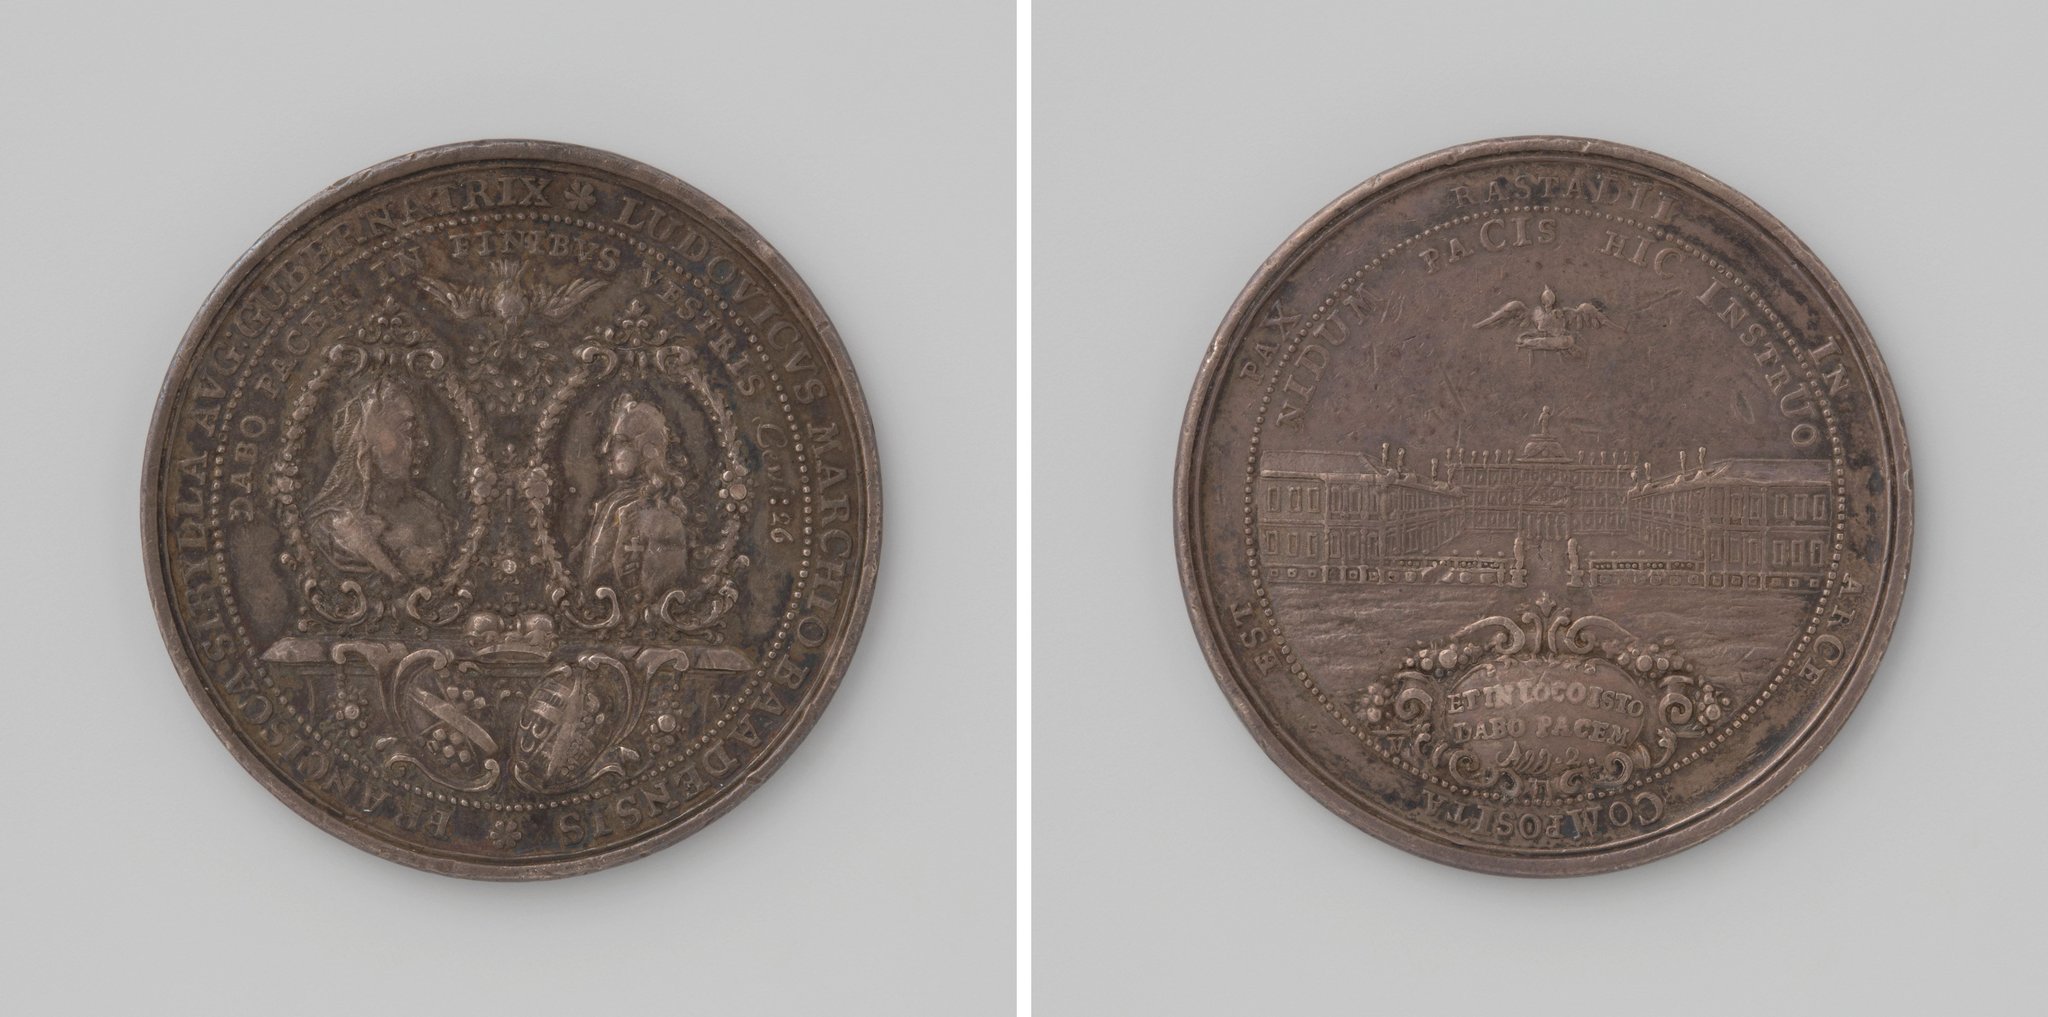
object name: history medal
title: Vrede van Rastatt, penning ter ere van Francisca Sybilla, prinses-weduwe van Baden-Baden en Lodewijk Georg, markgraaf van Baden-Baden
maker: georg wilhelm vestner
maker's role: medailleur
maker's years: 1677-1740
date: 1714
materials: silver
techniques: striking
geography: nuremberg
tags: lodewijk georg (markgraaf van baden-baden), francisca sybilla (prinses van baden-baden), baden-württemberg, rastatt, vrede van rastatt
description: Zilveren penning. Voorzijde: borststuk vrouw en jongen ieder in krans van takken op altaar, waarvoor twee wapenschilden onder een kroon, daarboven duif met lauwerkrans in bek binnen omschrift. Keerzijde: gezicht op slot te Rastatt boven cartouche met opschrift, binnen omschrif